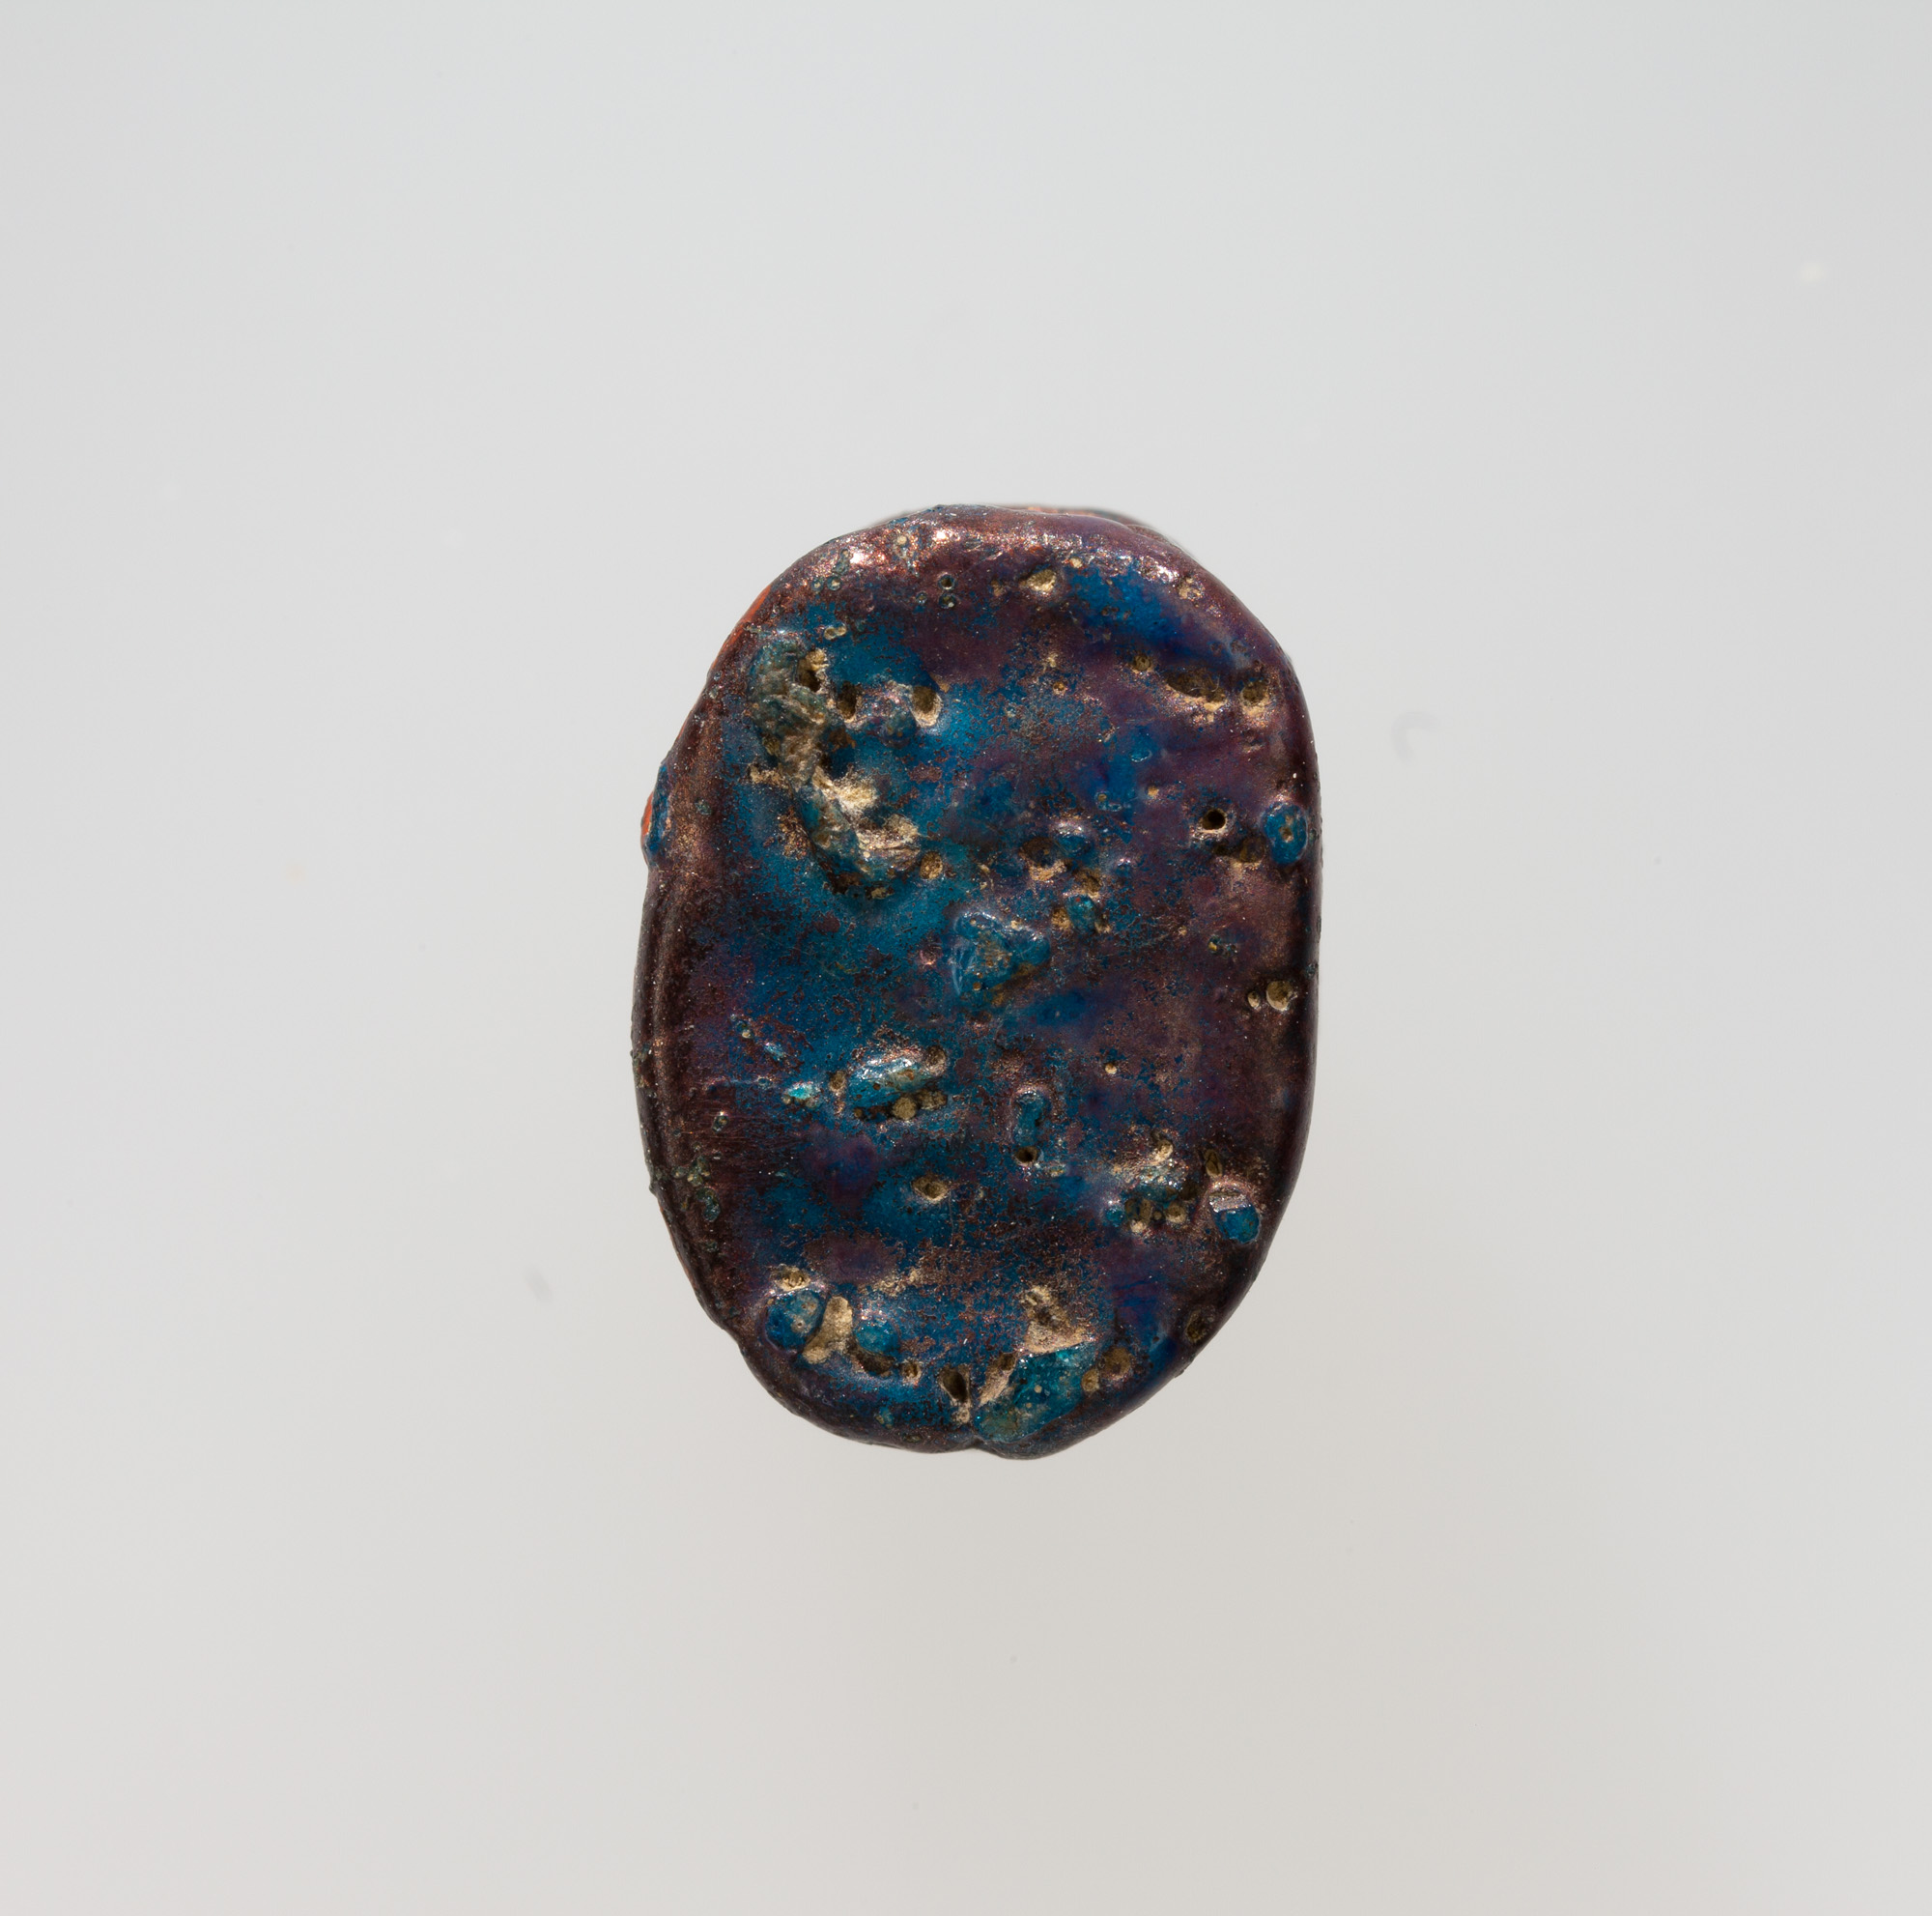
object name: scarab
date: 1479-1458 BCE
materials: faience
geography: egypt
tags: scarabs